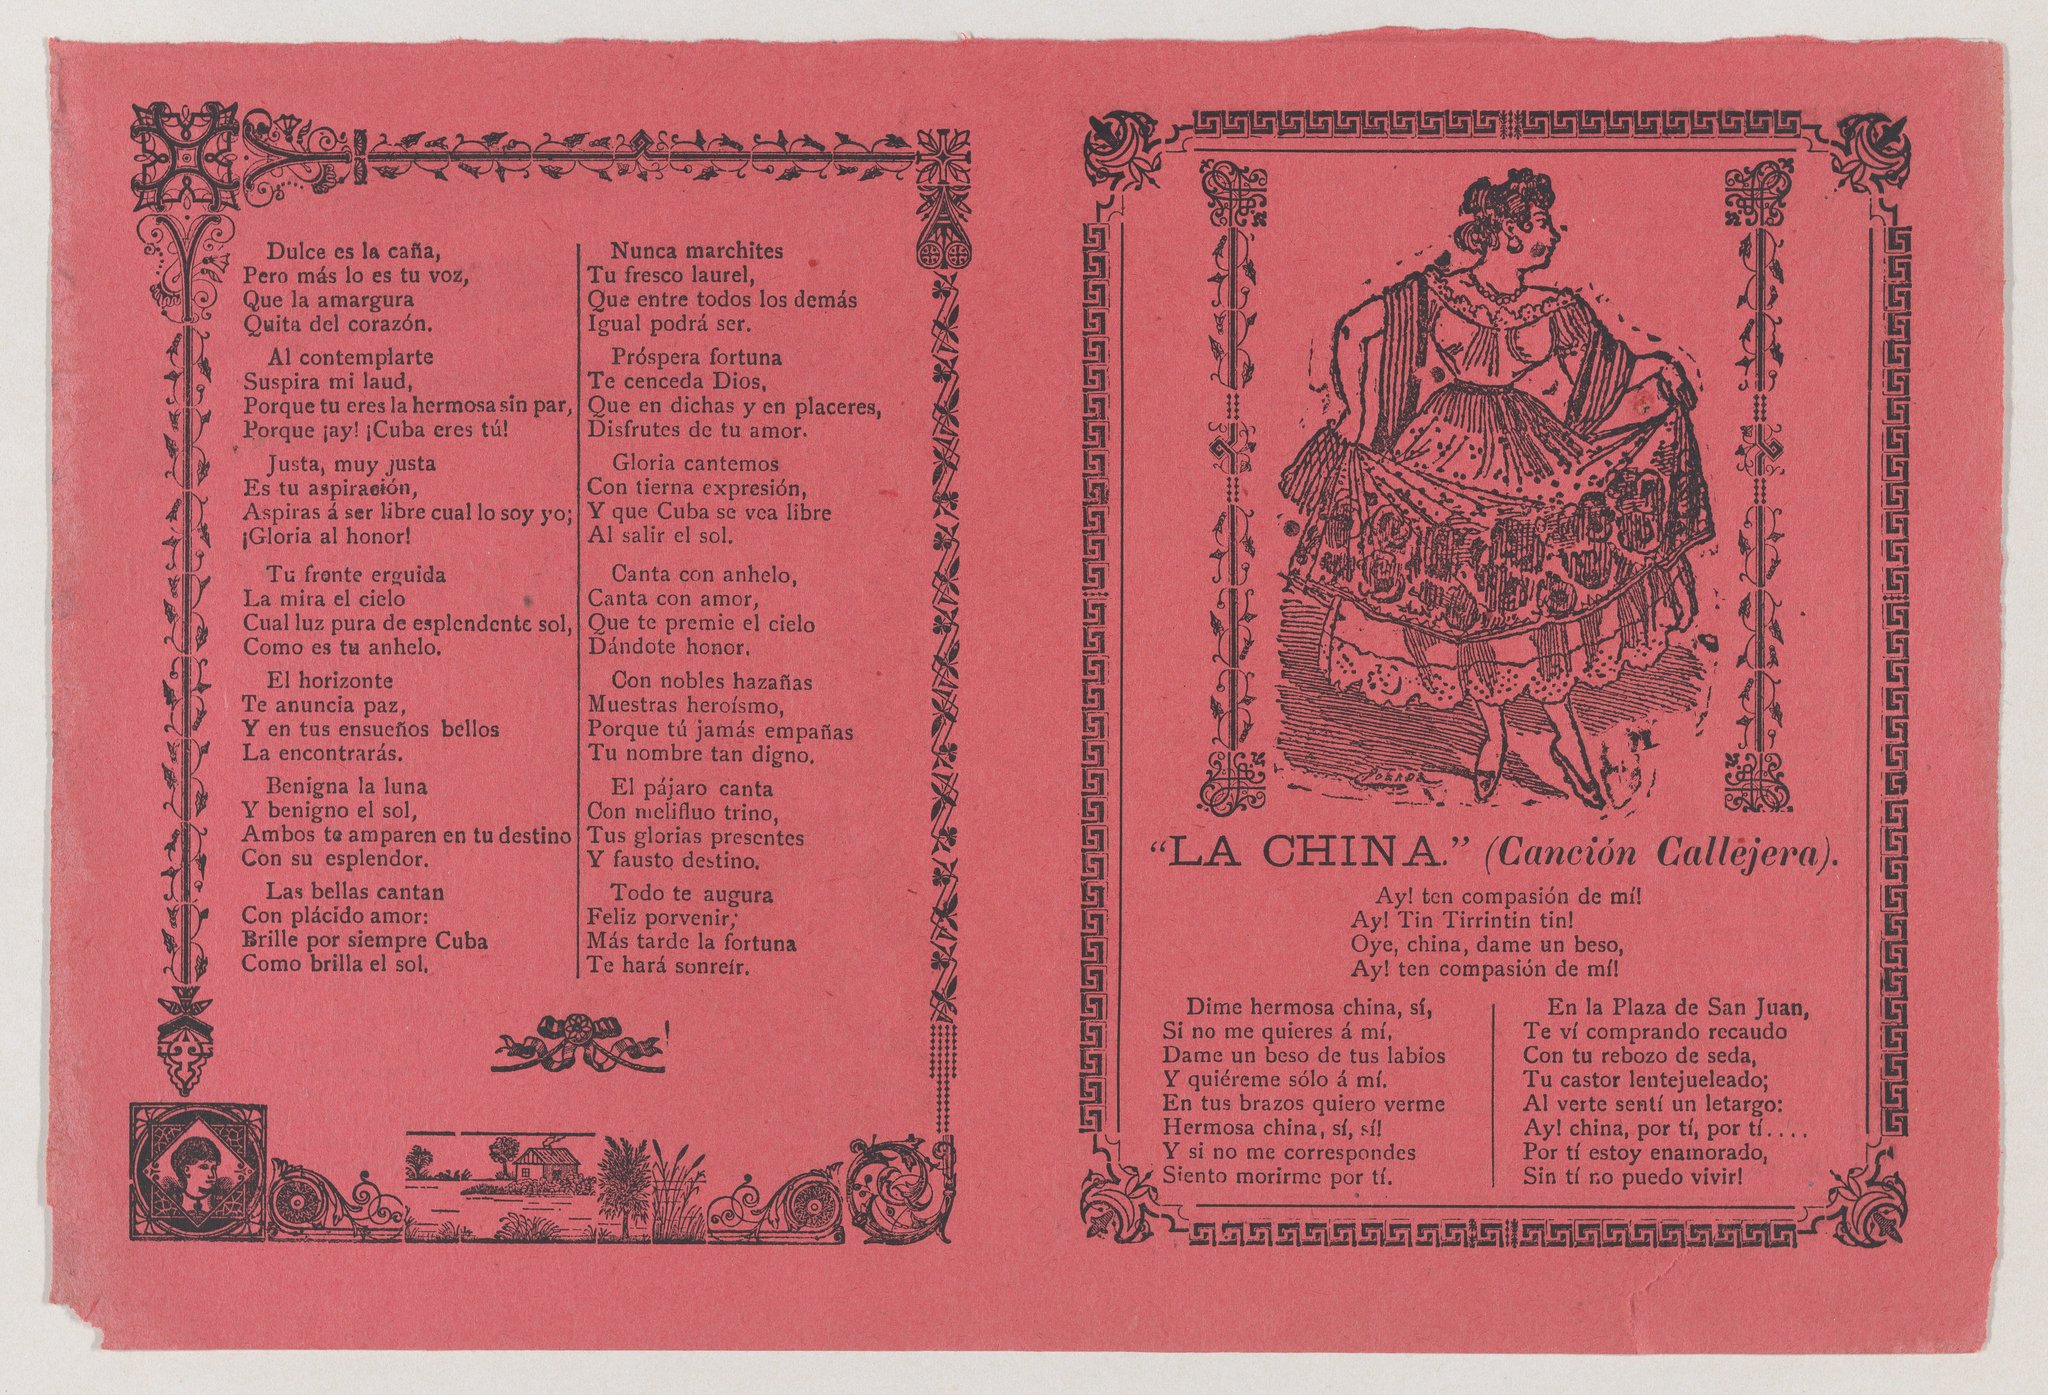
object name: print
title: A broadsheet with a popular song 'La China' on the recto, on the verso the dance of 'Cuba Libre'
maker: josé guadalupe posada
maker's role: artist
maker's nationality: mexican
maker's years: 1852-1913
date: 1900-1910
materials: paper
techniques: letterpress, lithography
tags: women